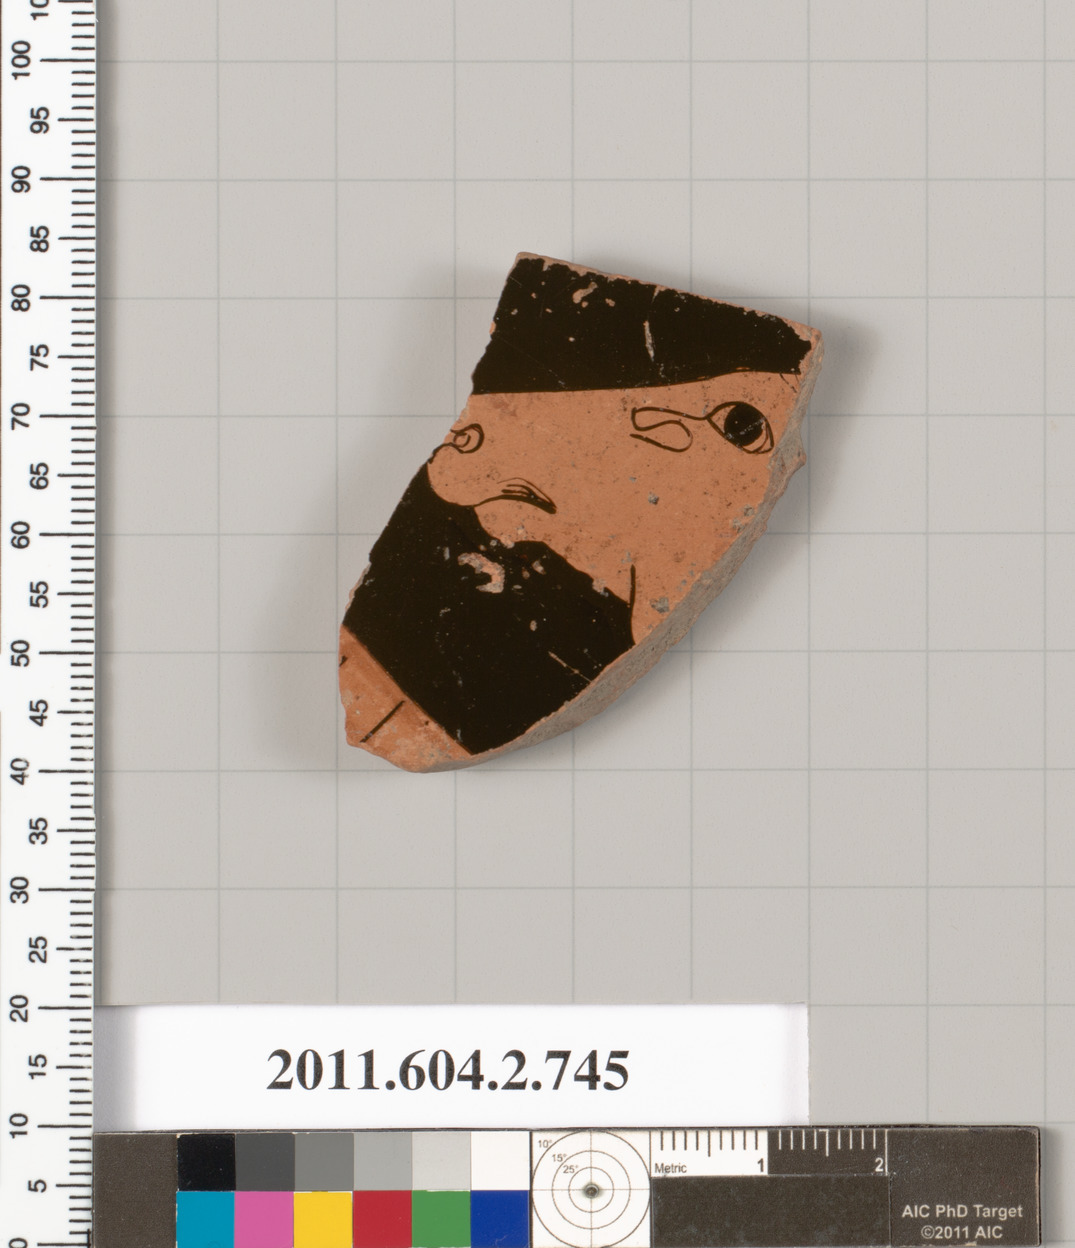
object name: calyx krater fragment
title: Terracotta fragment of a calyx-krater (bowl for mixing wine and water)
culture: greek, attic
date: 500-476 BCE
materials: terracotta